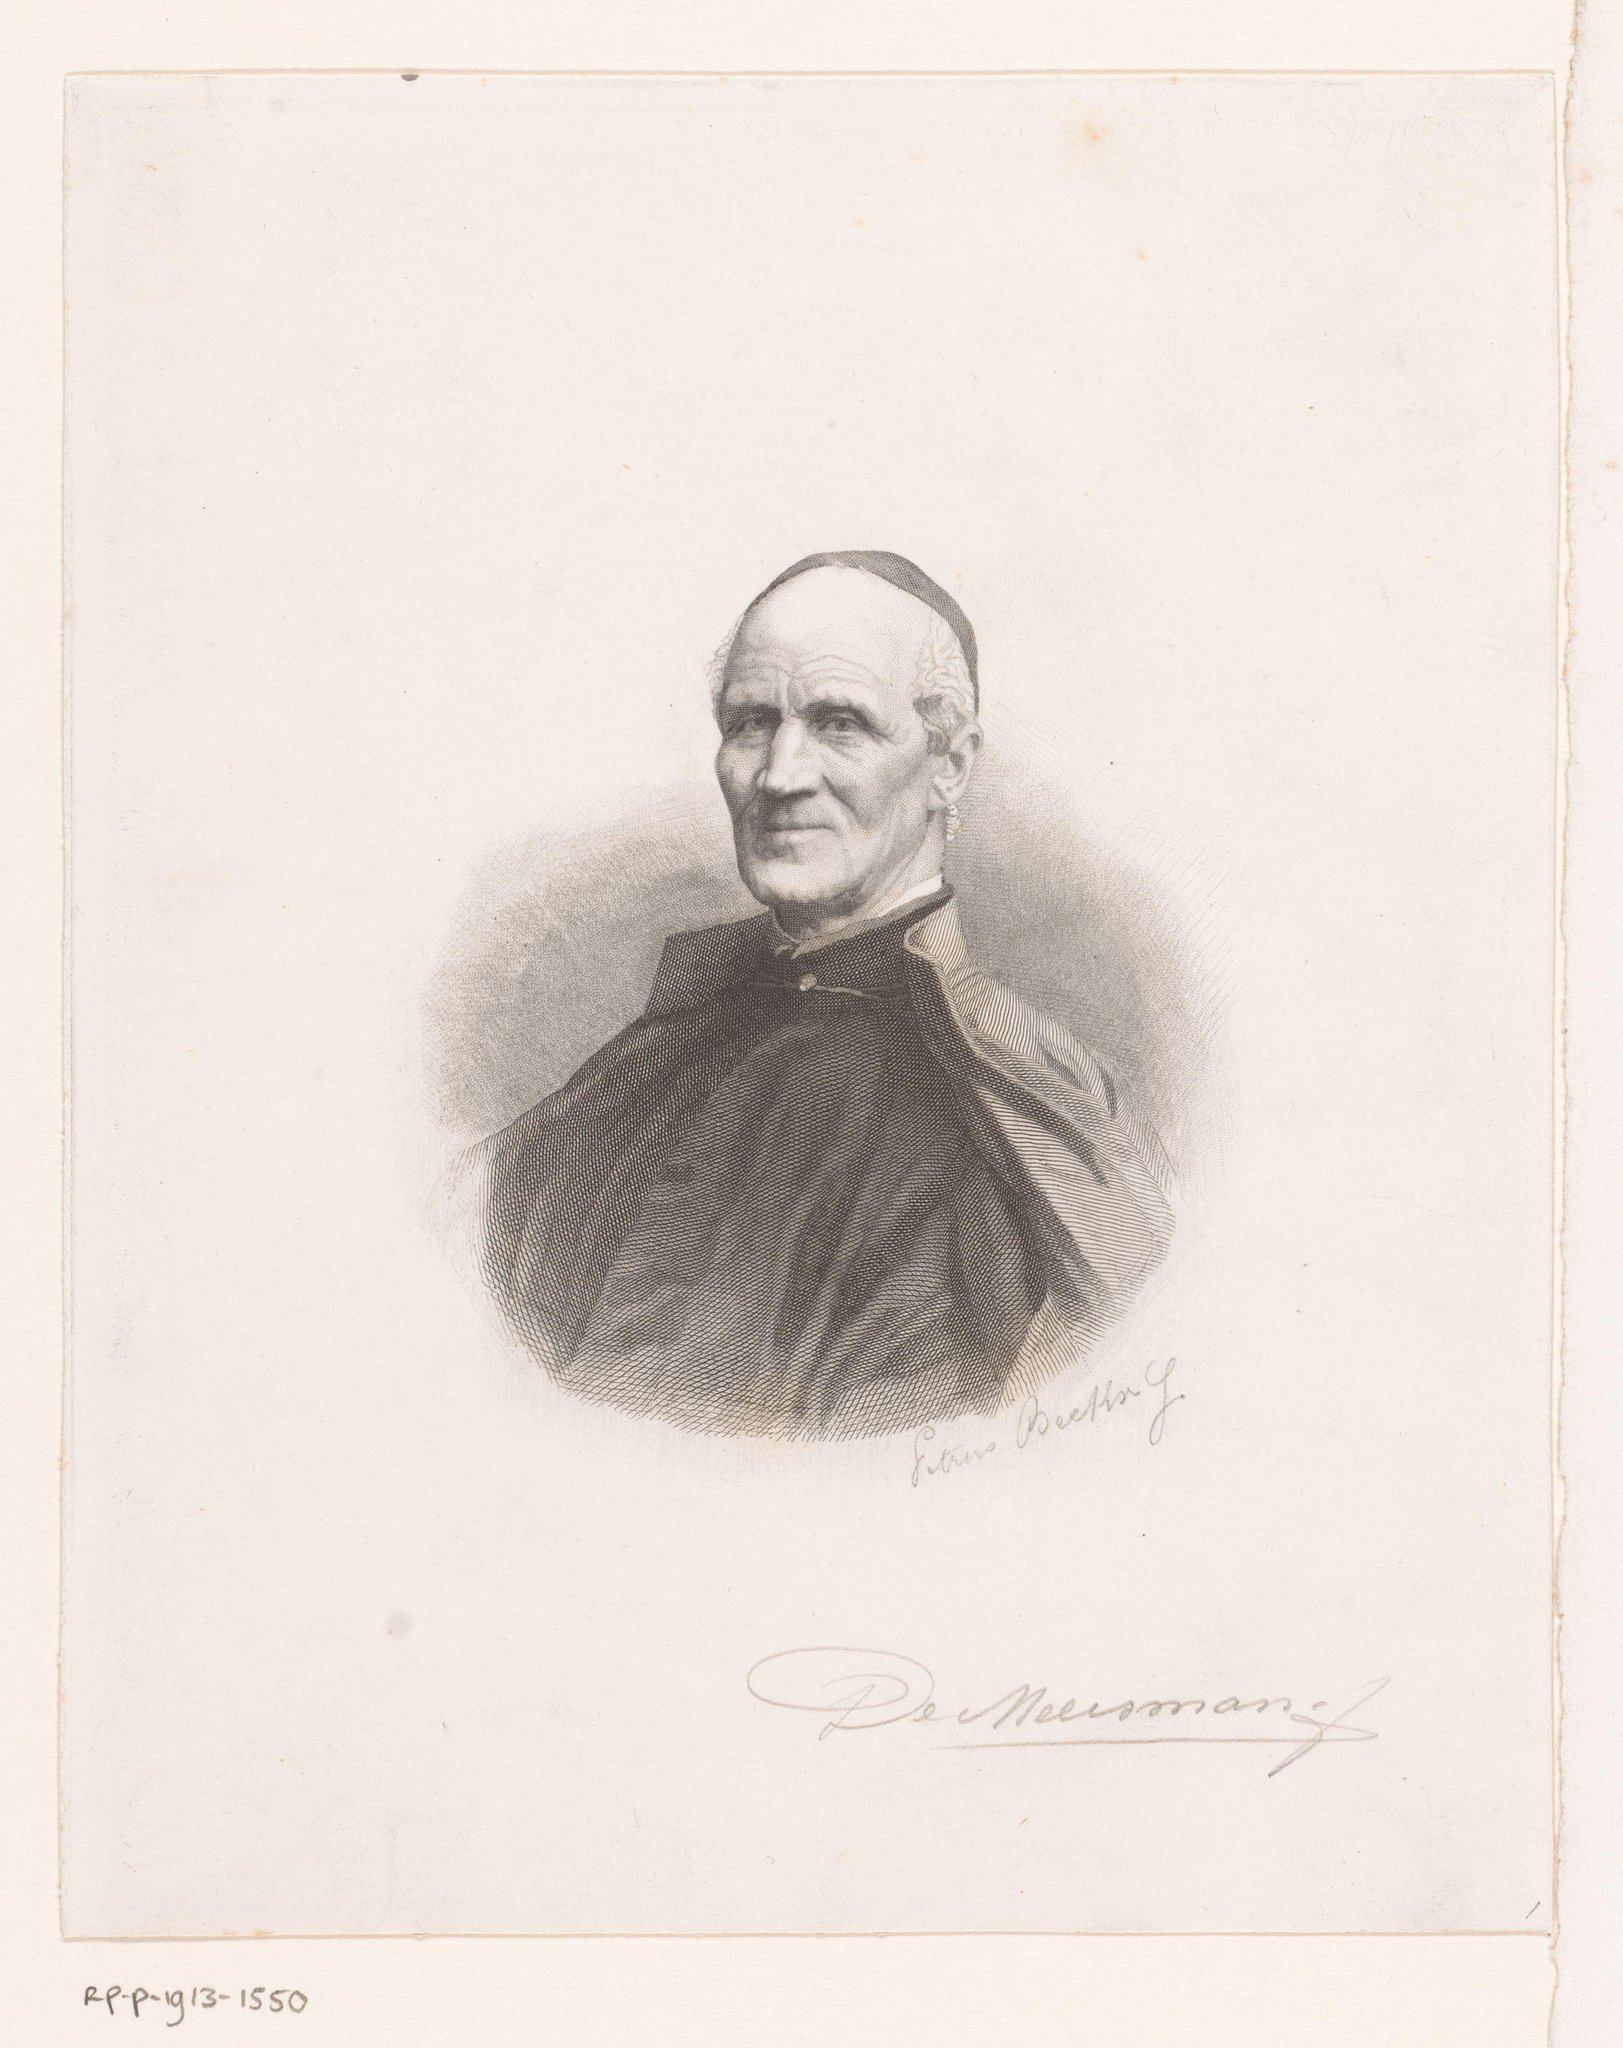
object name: print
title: Portret van Peter Jan Beckx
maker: françois de meersman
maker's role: print maker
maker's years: 1830-1905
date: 1840-1905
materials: paper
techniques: engraving, etching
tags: rome, priest, historical persons, old man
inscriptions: collector's mark: Lugt 2228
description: Peter Jan Beckx was generaal van de Jezuïeten orde.